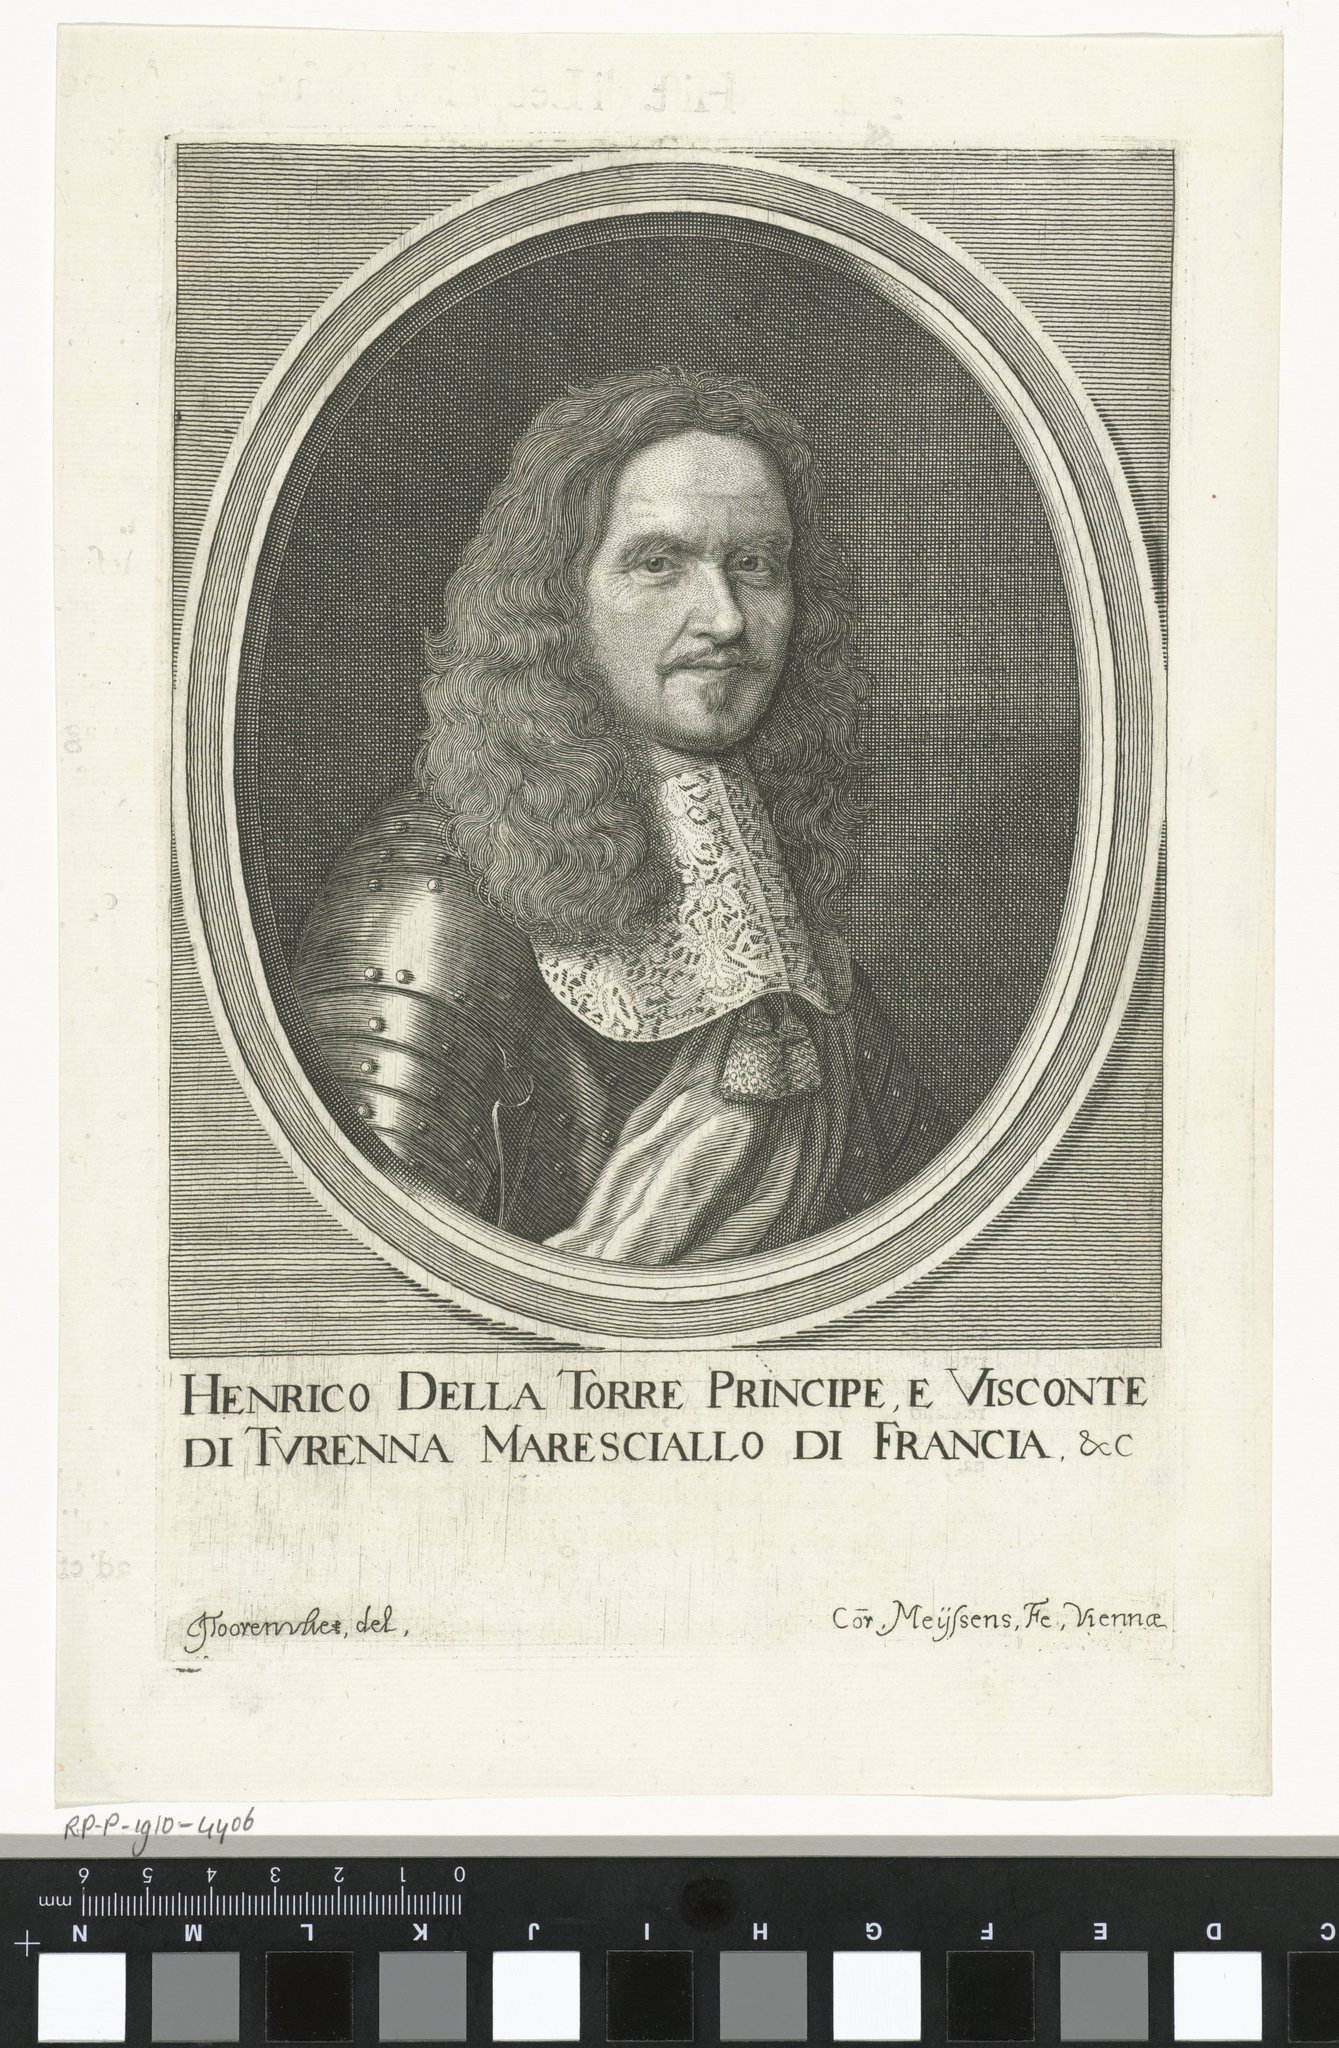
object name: book illustration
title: Portret van Henri de Latour d'Auvergne, vicomte de Turenne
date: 1670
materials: paper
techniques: engraving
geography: vienna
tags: sedan, sasbach, maarschalk, legeraanvoerder, henri de la tour d'auvergne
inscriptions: collector's mark: Lugt 2228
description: Prent gebruikt in: Gualdo Priorato, Galeazzo. Historia di Leopoldo Cesare, (...). 3 dln. Wenen, Giovanni Battista Hacque, 1670-1674, dl. 1.